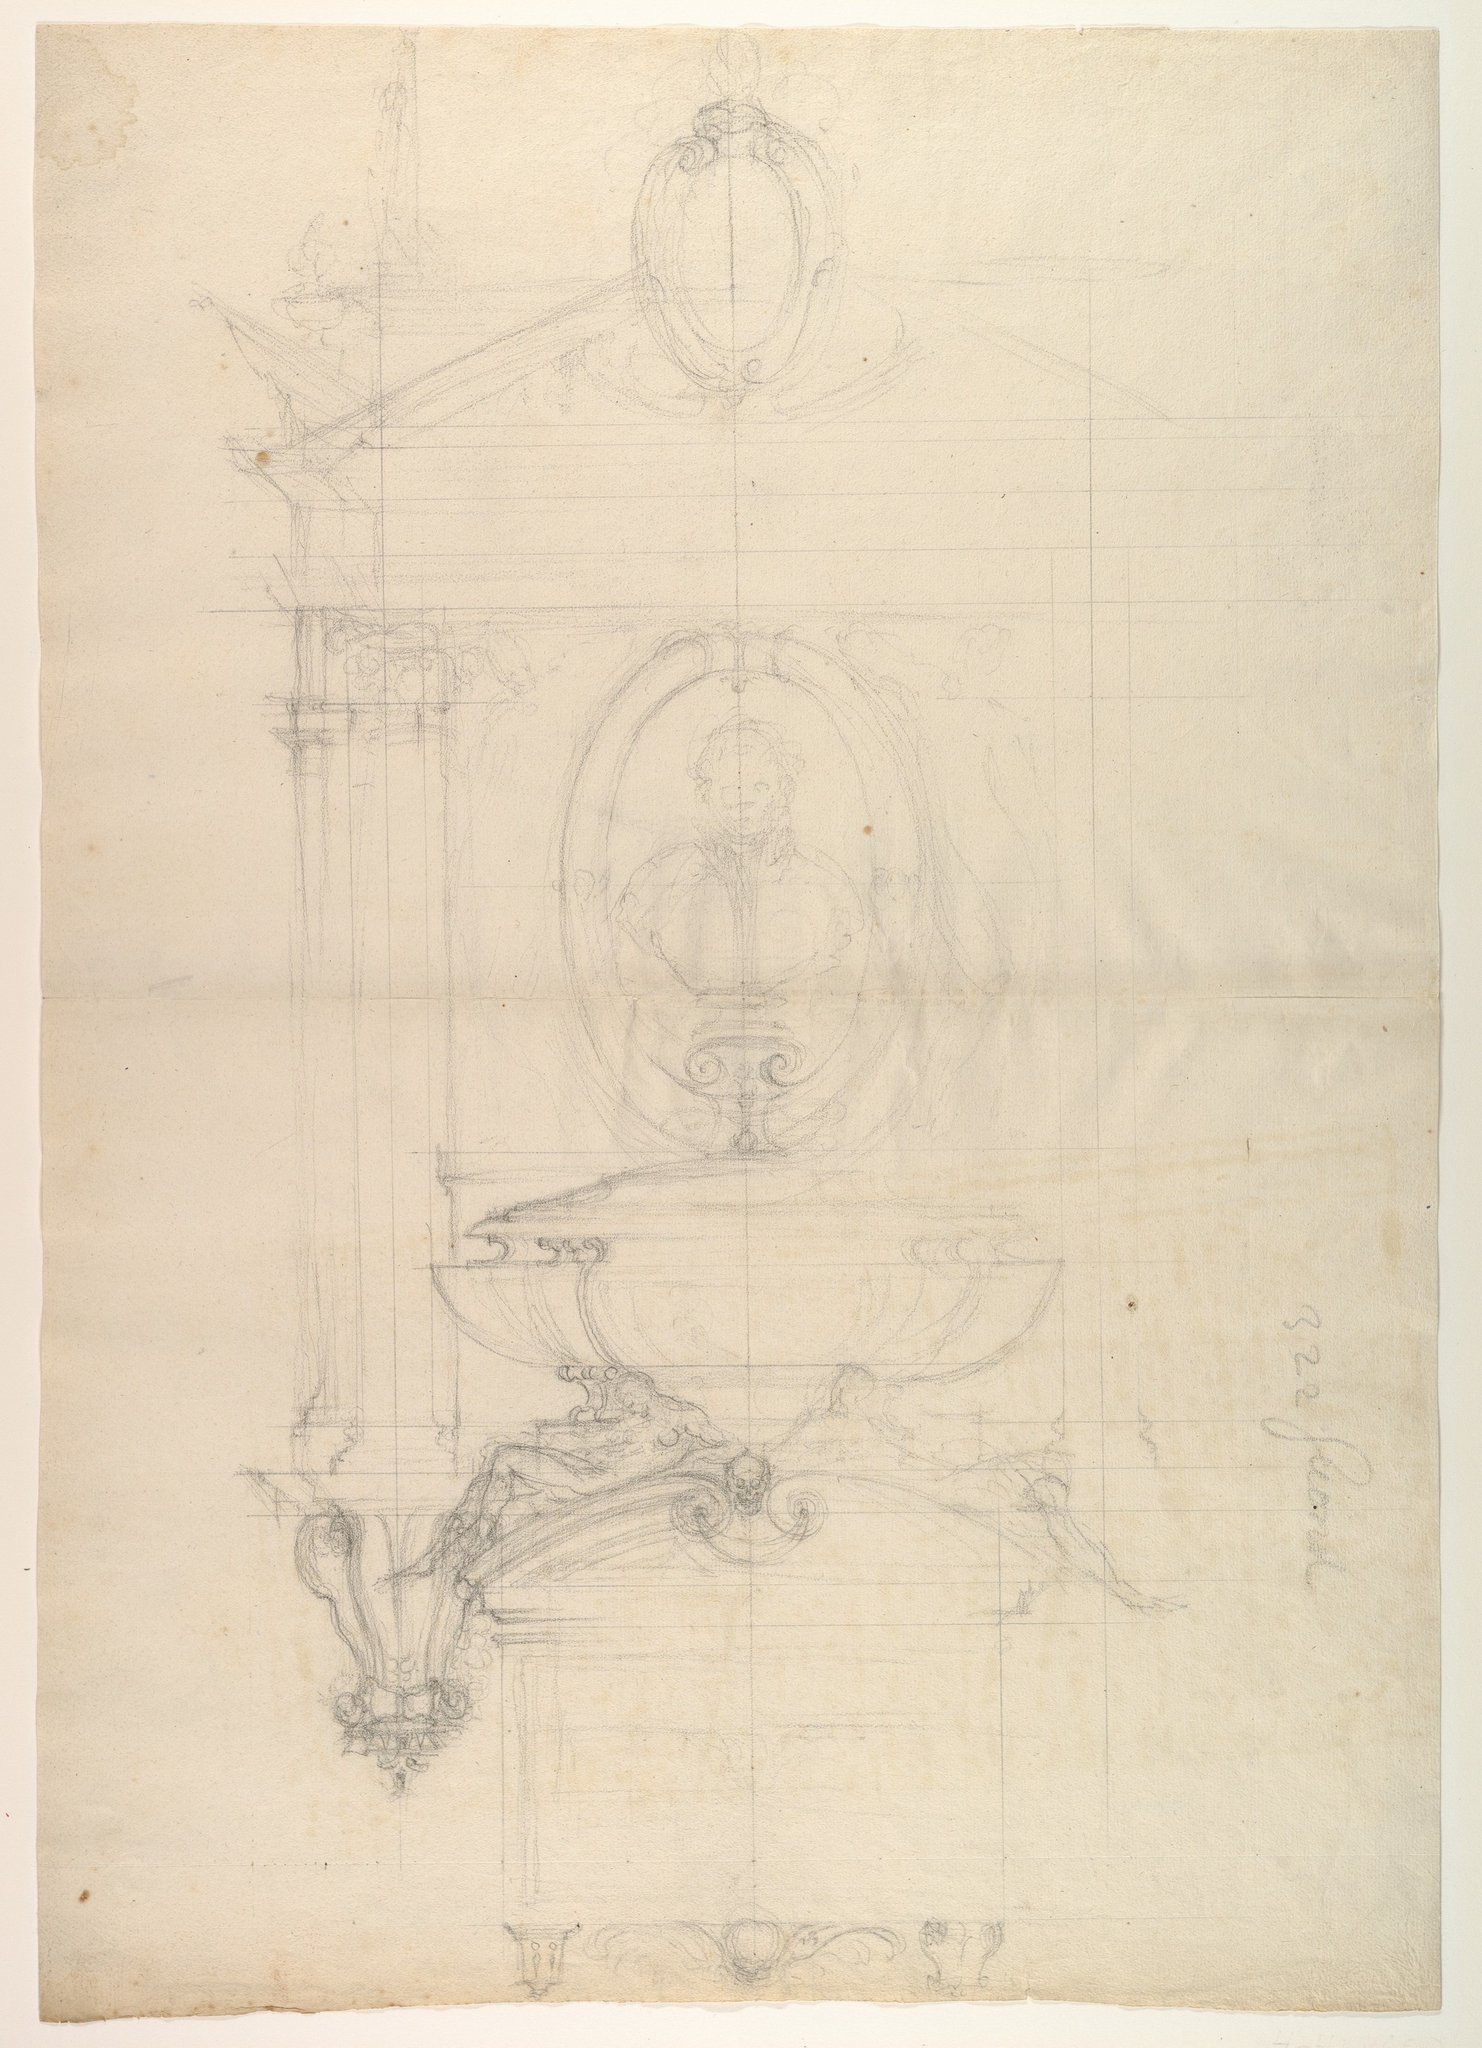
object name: drawing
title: Design for the Tomb of Christophe de Thou (d. 1582)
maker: barthélemy prieur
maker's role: artist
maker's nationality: french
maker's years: 1536-1611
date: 1501-1600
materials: graphite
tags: tombs